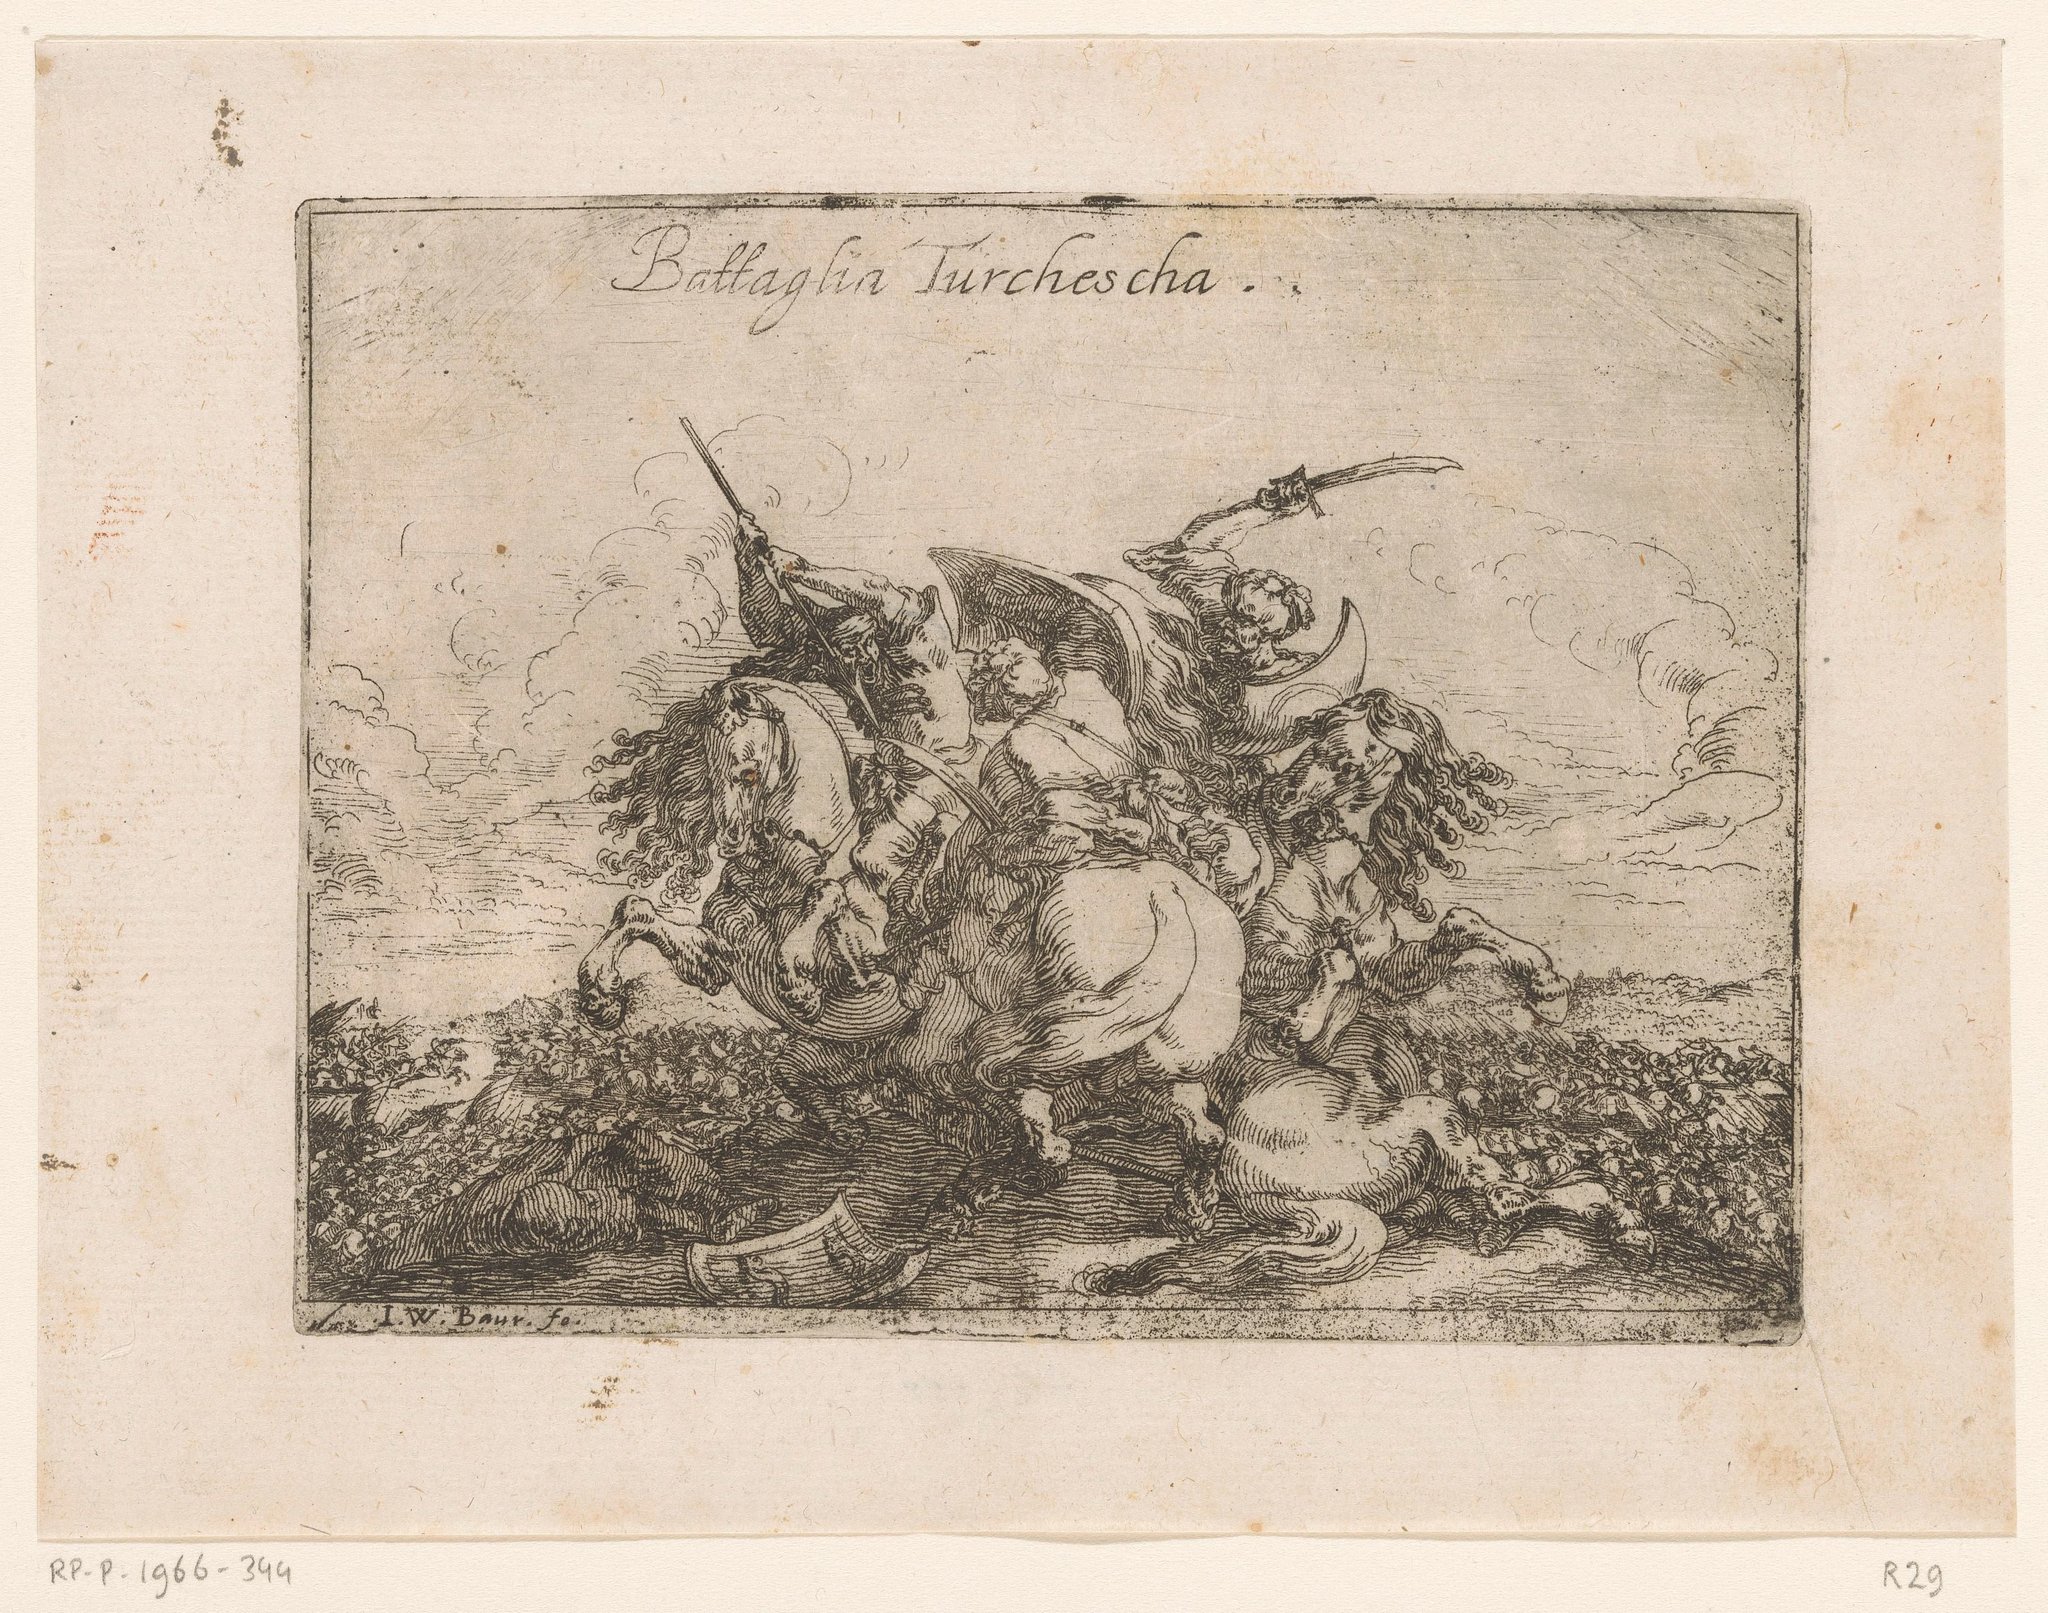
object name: print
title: Battaglia Turchescha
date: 1633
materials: paper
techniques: etching, intaglio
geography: italy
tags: asiatic races and peoples: turks, battle (+ infantry), battle (+ cavalry, horsemen)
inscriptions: collector's mark: Lugt 5k, collector's mark: Lugt 2228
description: Zesde prent uit de serie 'Veldslagen door verschillende volkeren', bestaand uit een titelprent en dertien prenten.